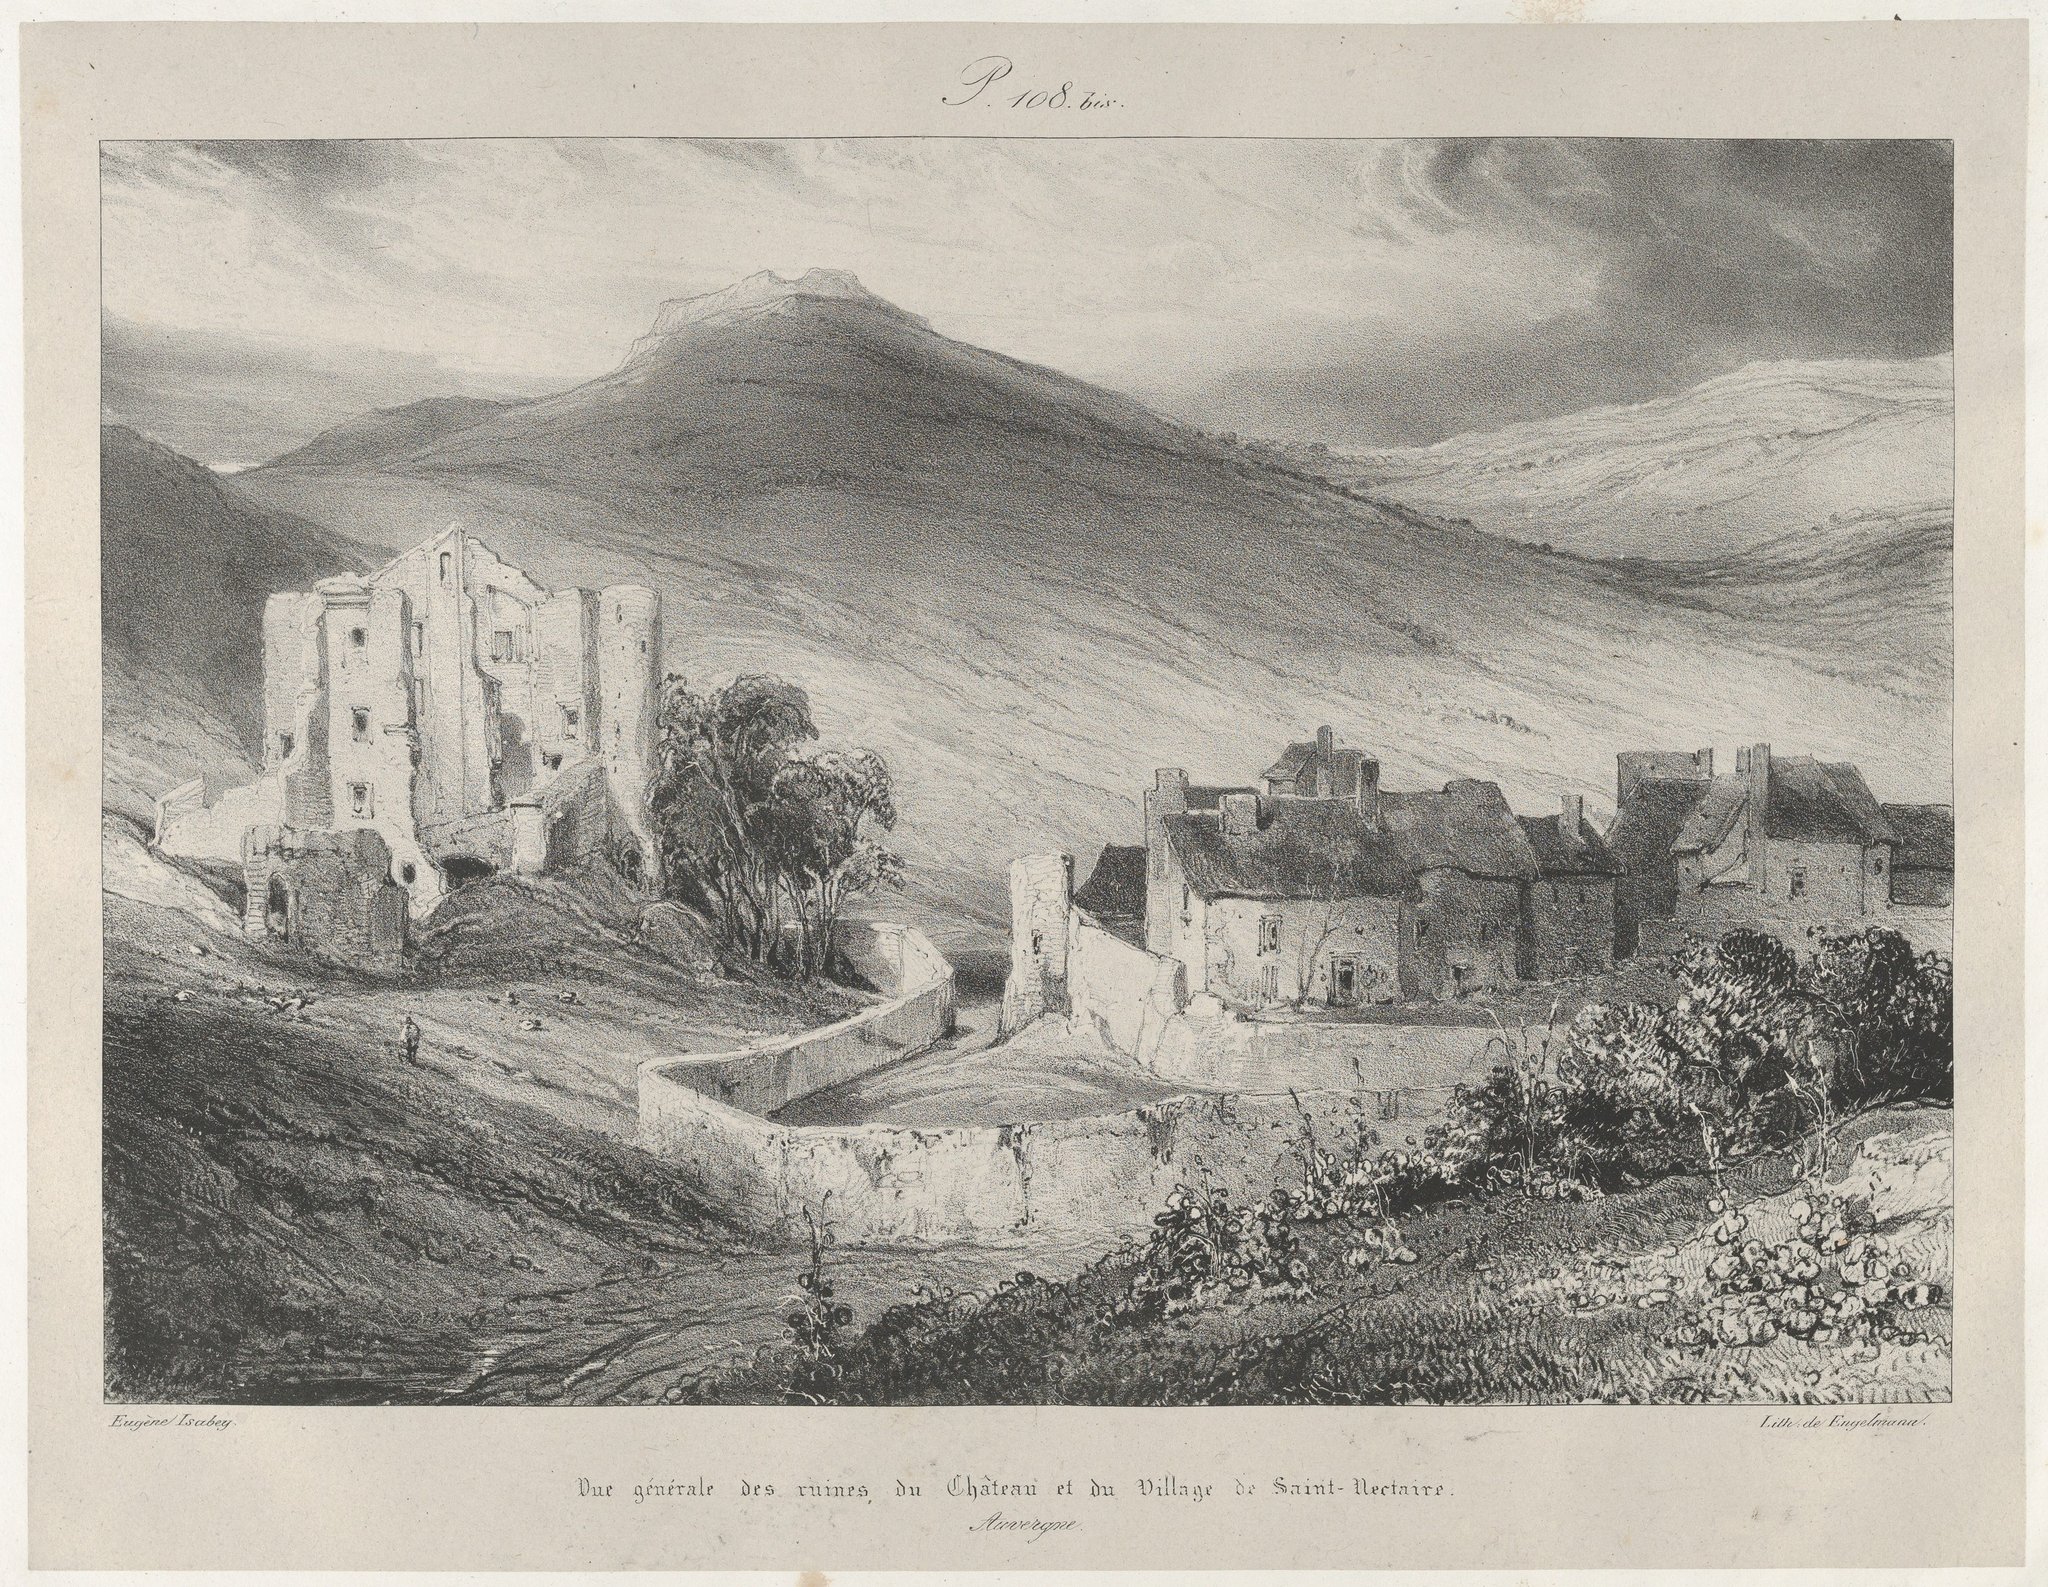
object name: print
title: General View of Castle Ruins and of The Village of Saint-Necataire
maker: eugène isabey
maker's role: artist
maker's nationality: french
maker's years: 1803-1886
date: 1831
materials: paper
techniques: printmaking, lithograph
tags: ruins,villages